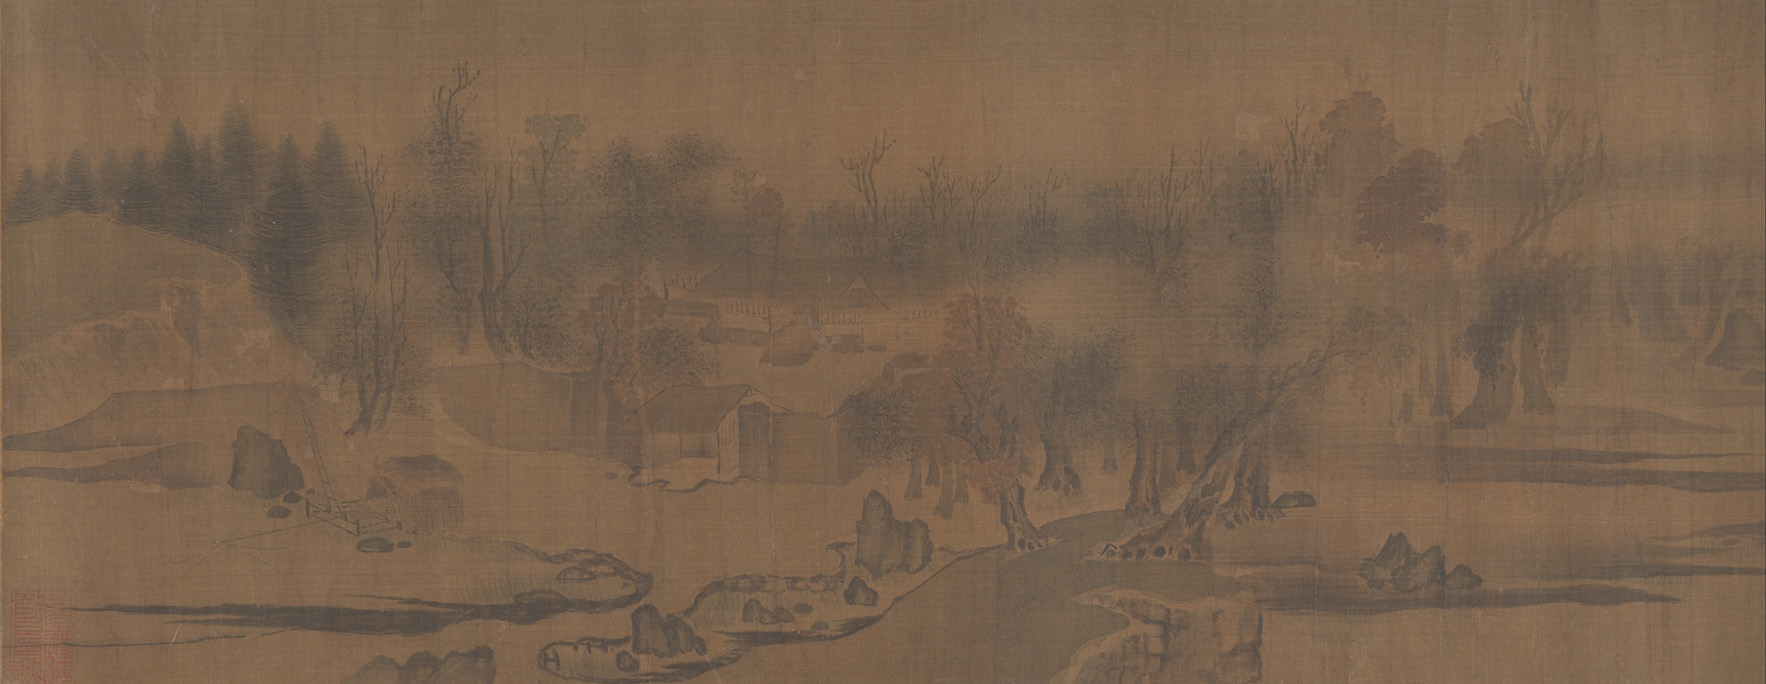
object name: handscroll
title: River Village in Autumn Dawn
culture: chinese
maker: zhao lingrang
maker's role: artist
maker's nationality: chinese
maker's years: 1070-1100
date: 1201-1300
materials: ink, silk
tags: villages,rivers,landscapes